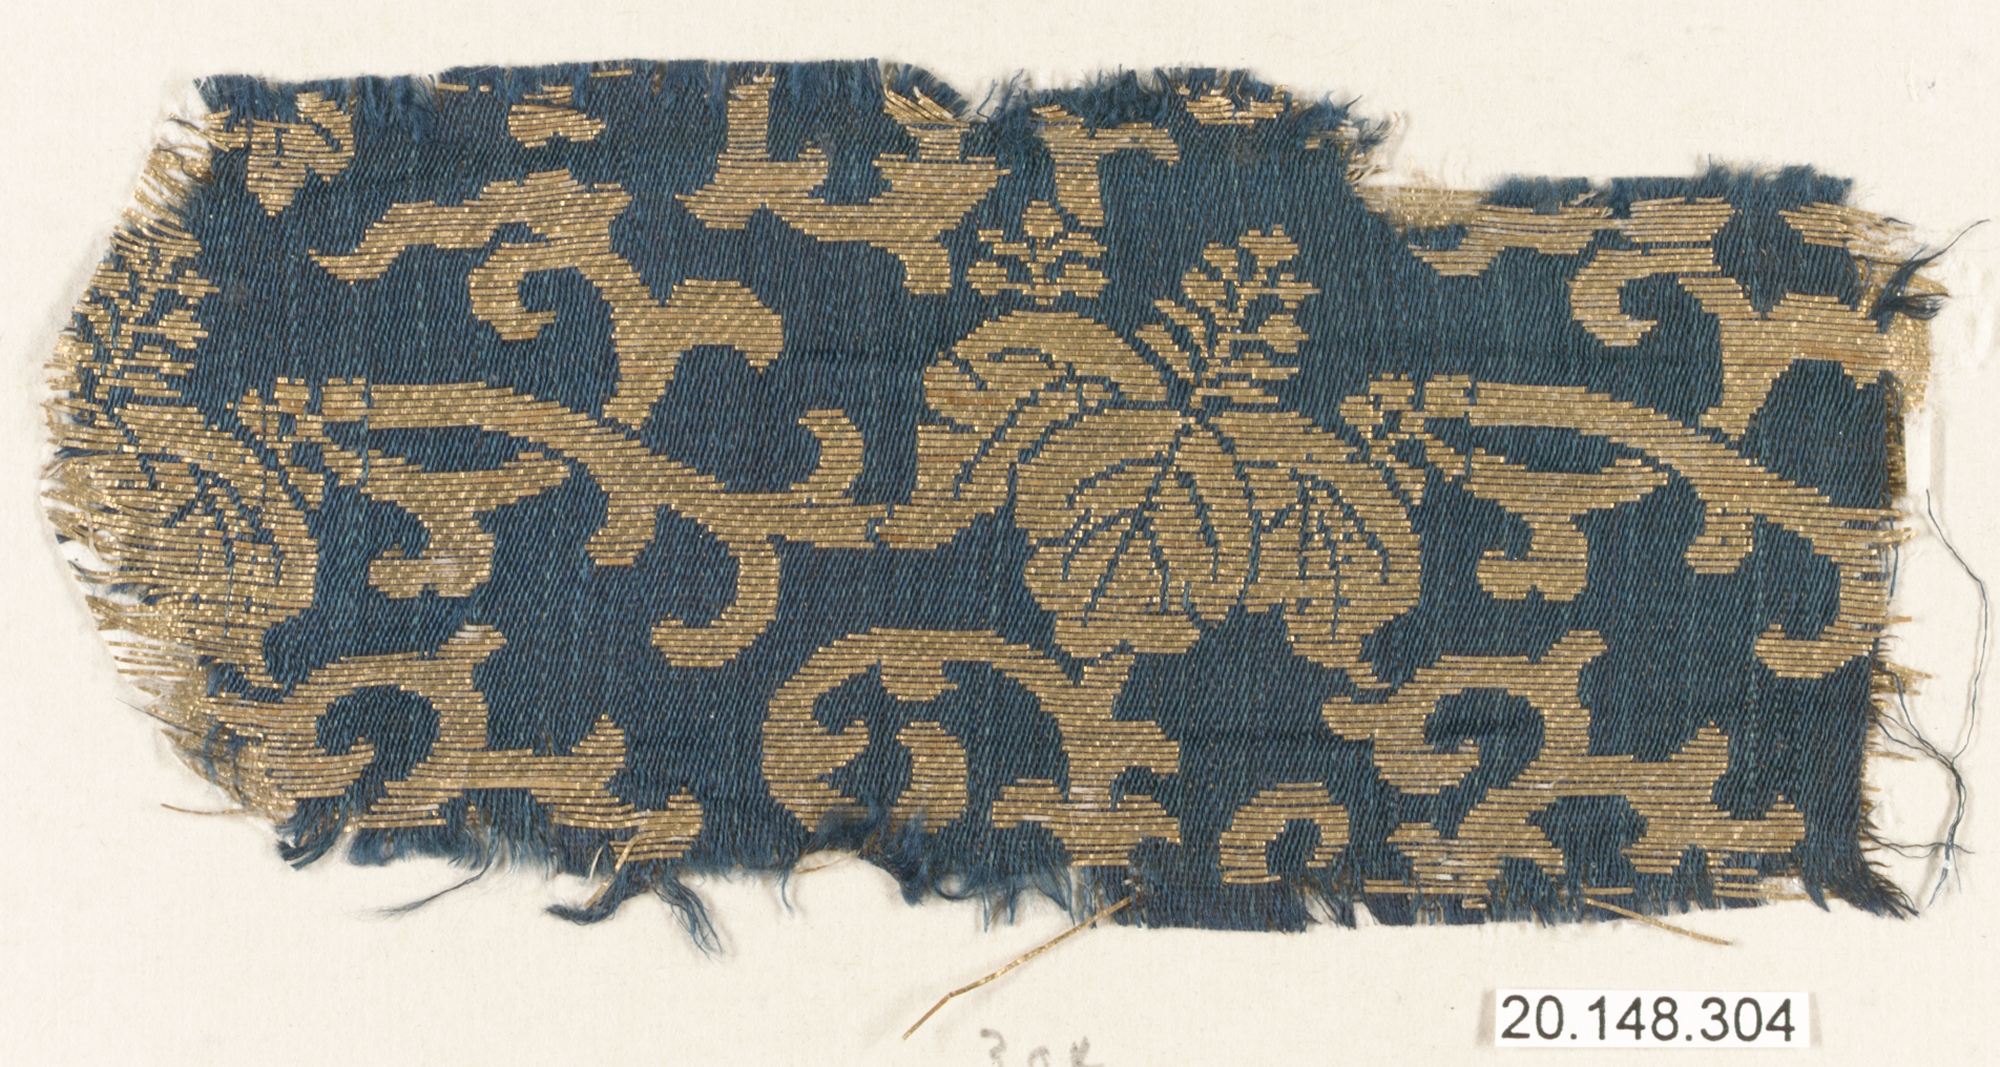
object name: piece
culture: japanese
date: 1701-1800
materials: silk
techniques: compound weave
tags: leaves